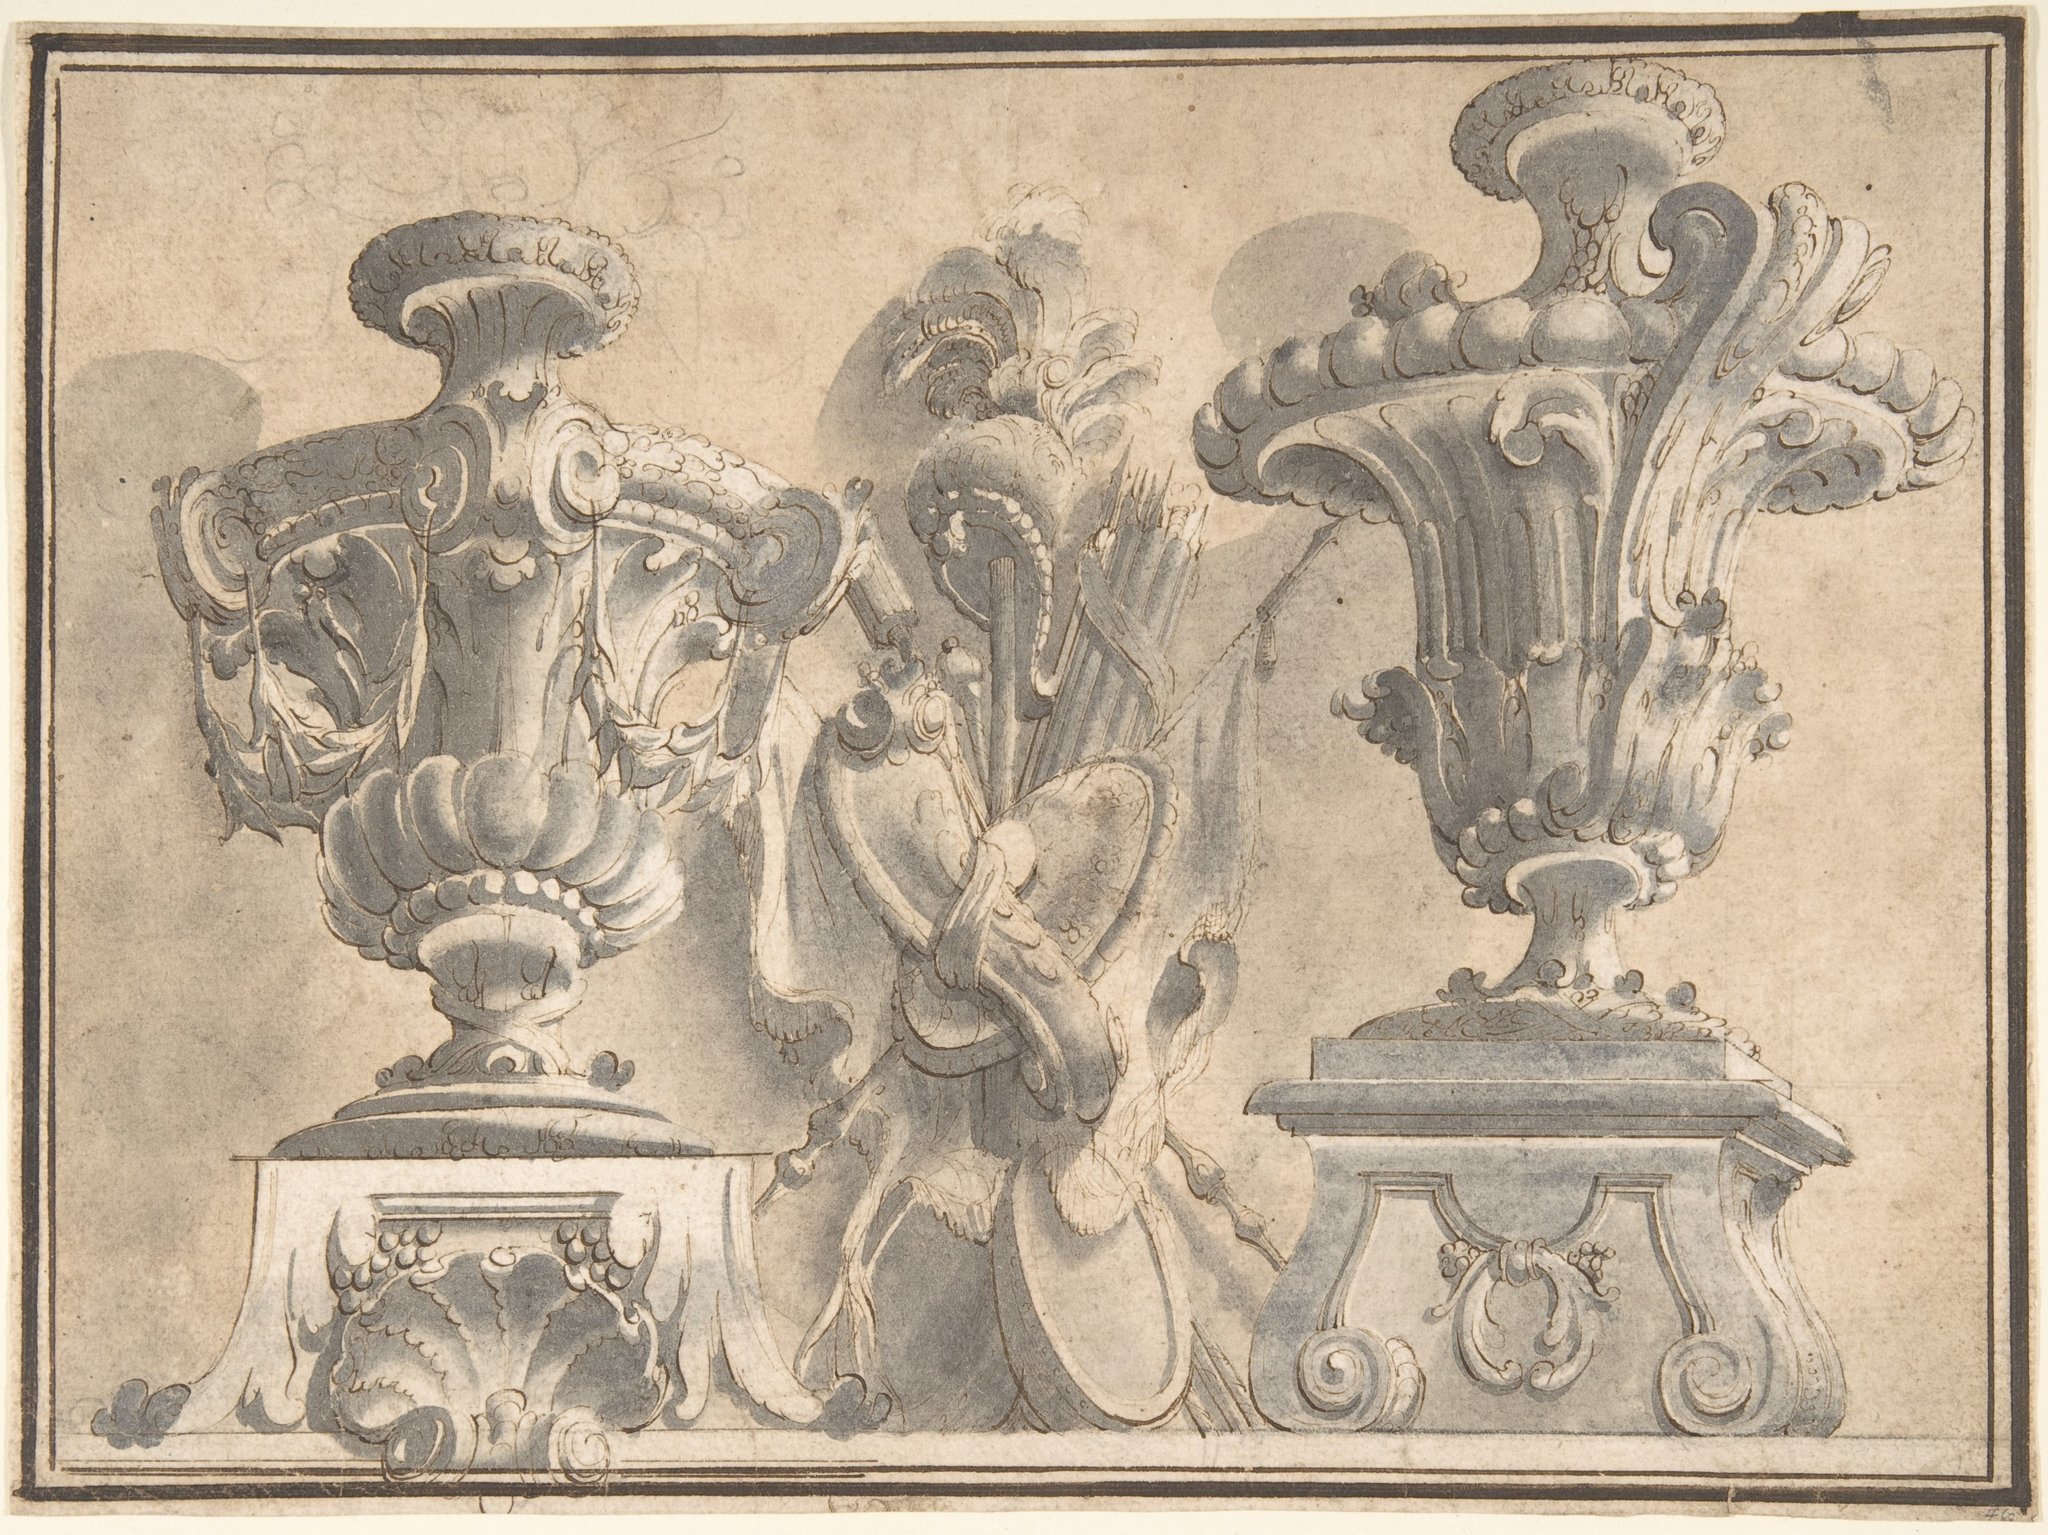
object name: drawing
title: Ornamental Design with Two Urns and a Trophy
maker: anonymous, italian, piedmontese, 18th century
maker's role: artist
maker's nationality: italian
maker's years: 1700-1800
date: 1700-1780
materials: chalk, ink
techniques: brush, pen, wash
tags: ornament,trophies,urns